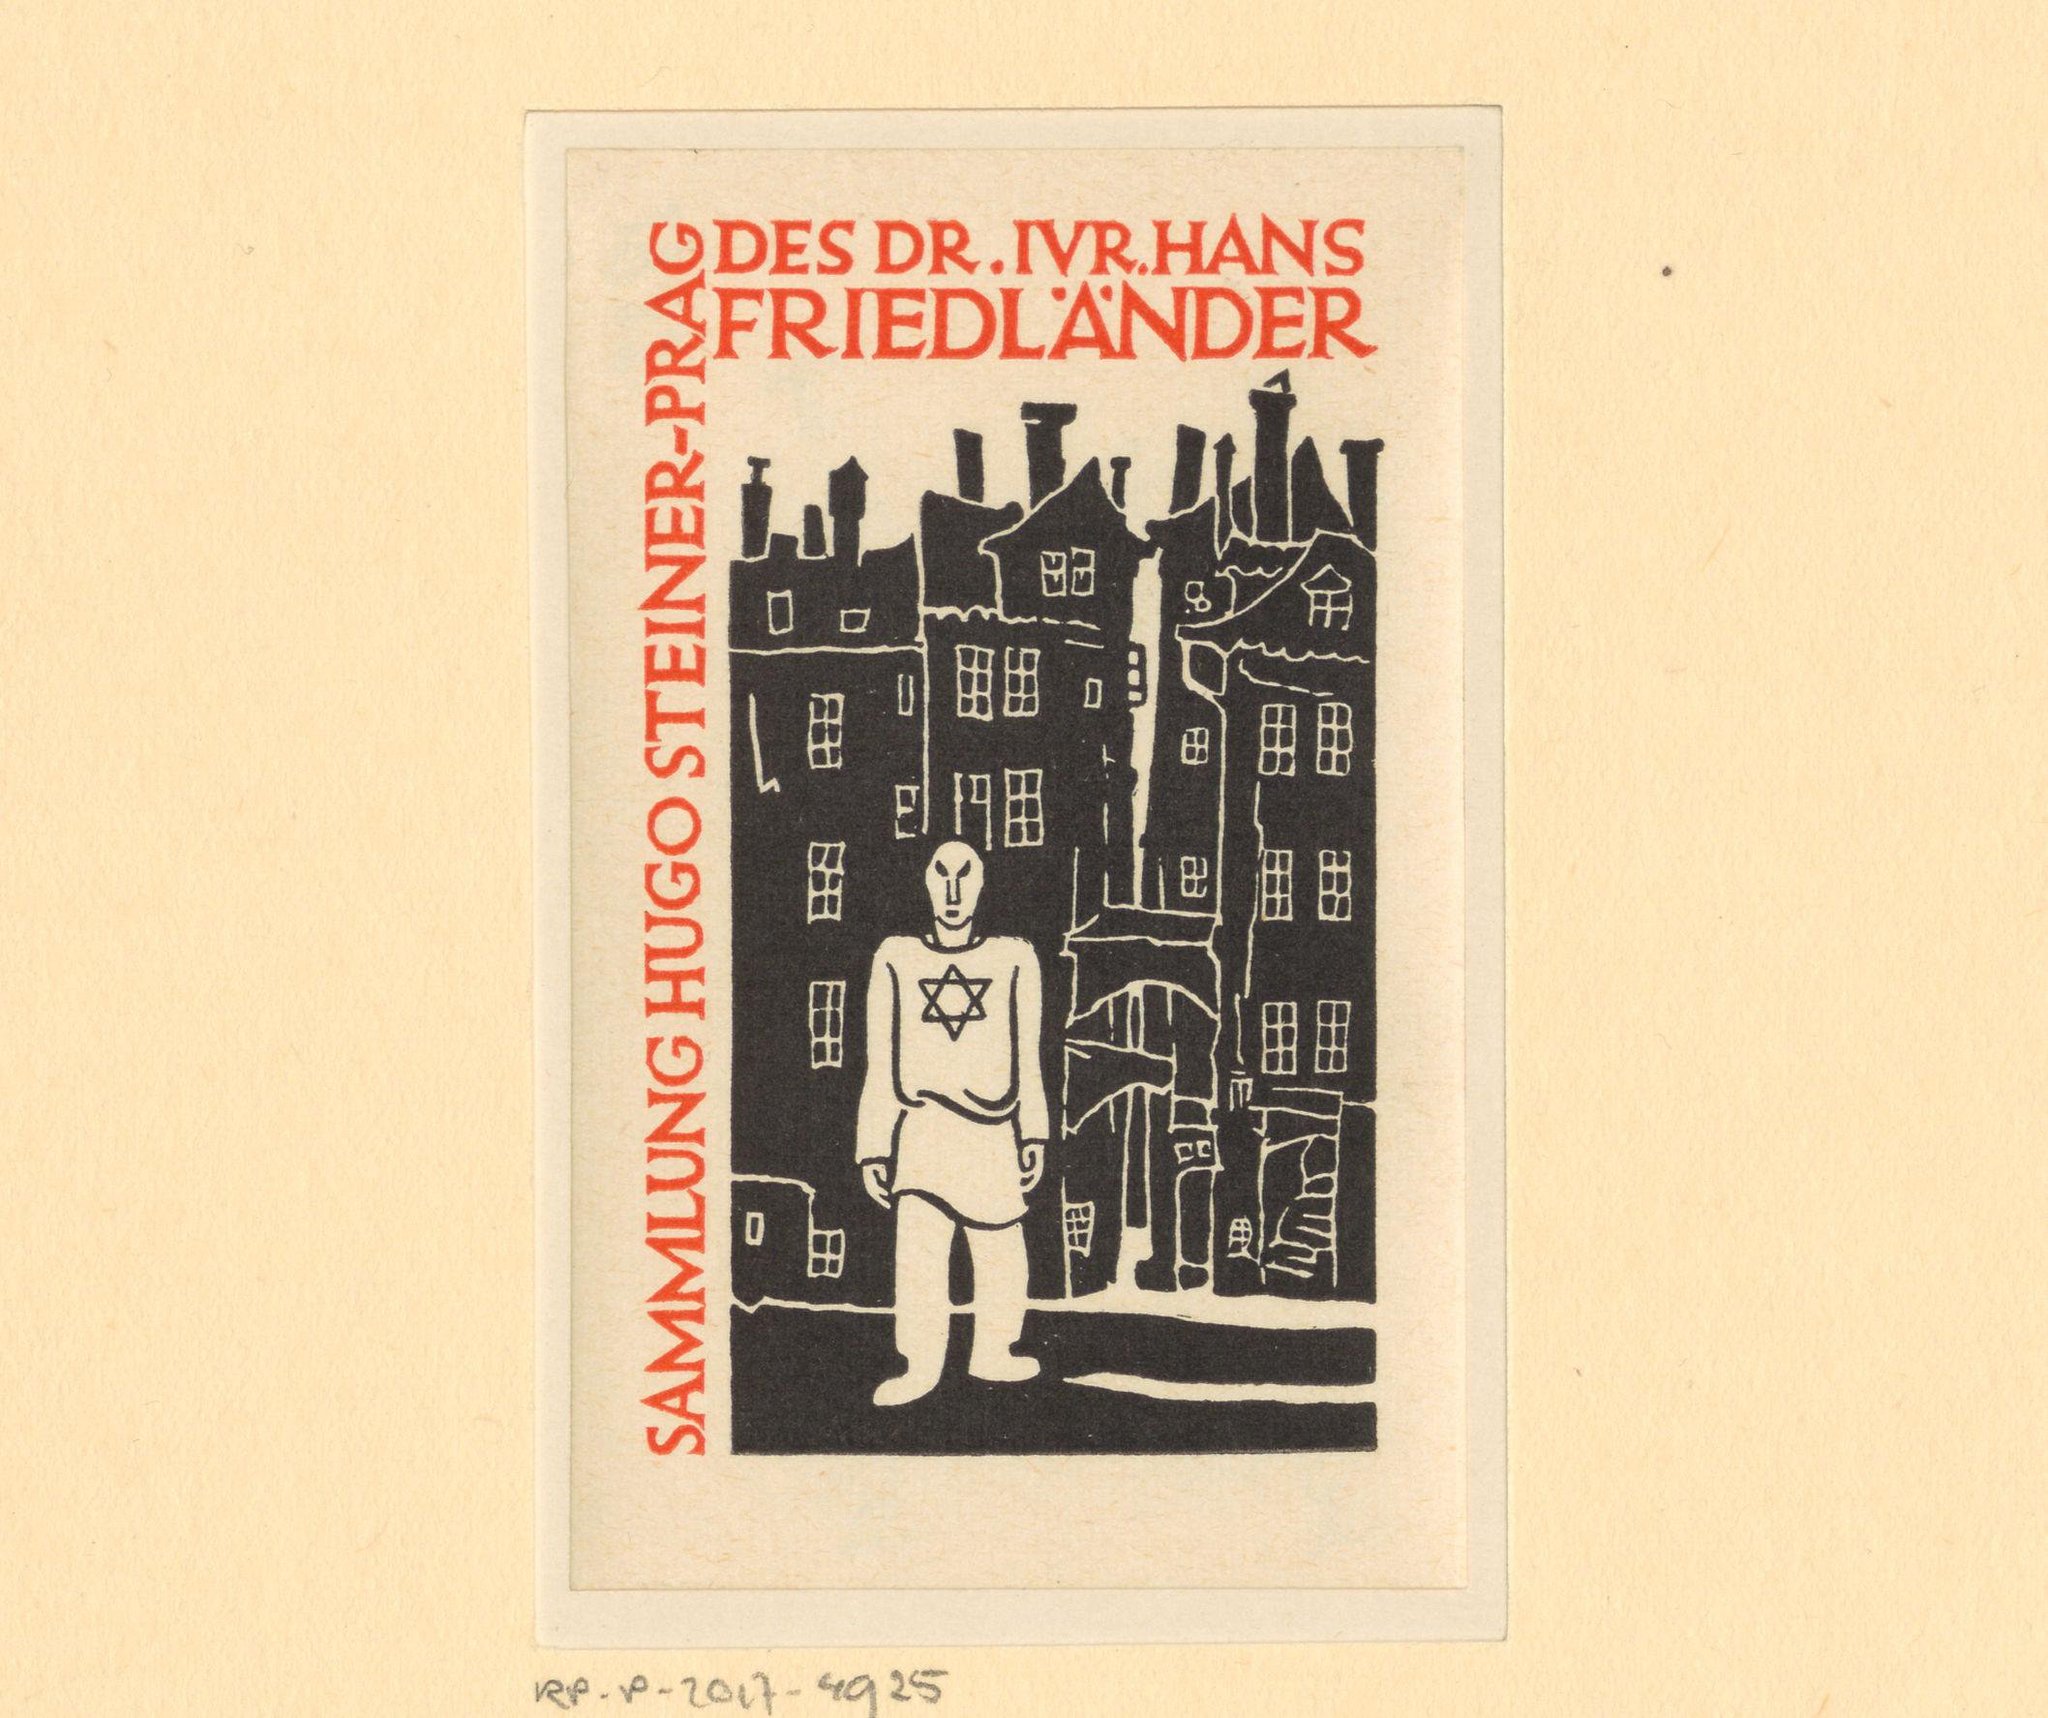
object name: bookplate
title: Ex libris van Hans Friedländer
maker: Anonymous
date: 1937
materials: paper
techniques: printing block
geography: germany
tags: urban housing, standing figure, jewish religion and culture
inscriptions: inscription: ‘Hugo Steiner-Prag, Cl. 1937 / Tent. Konstfackskolan 1951 nr. 237’, inscription: ‘37 / Dr. mr. Hans Friedländer / Prag / Speciali[...] für die / Sammlung Steiner-Prag (?)’